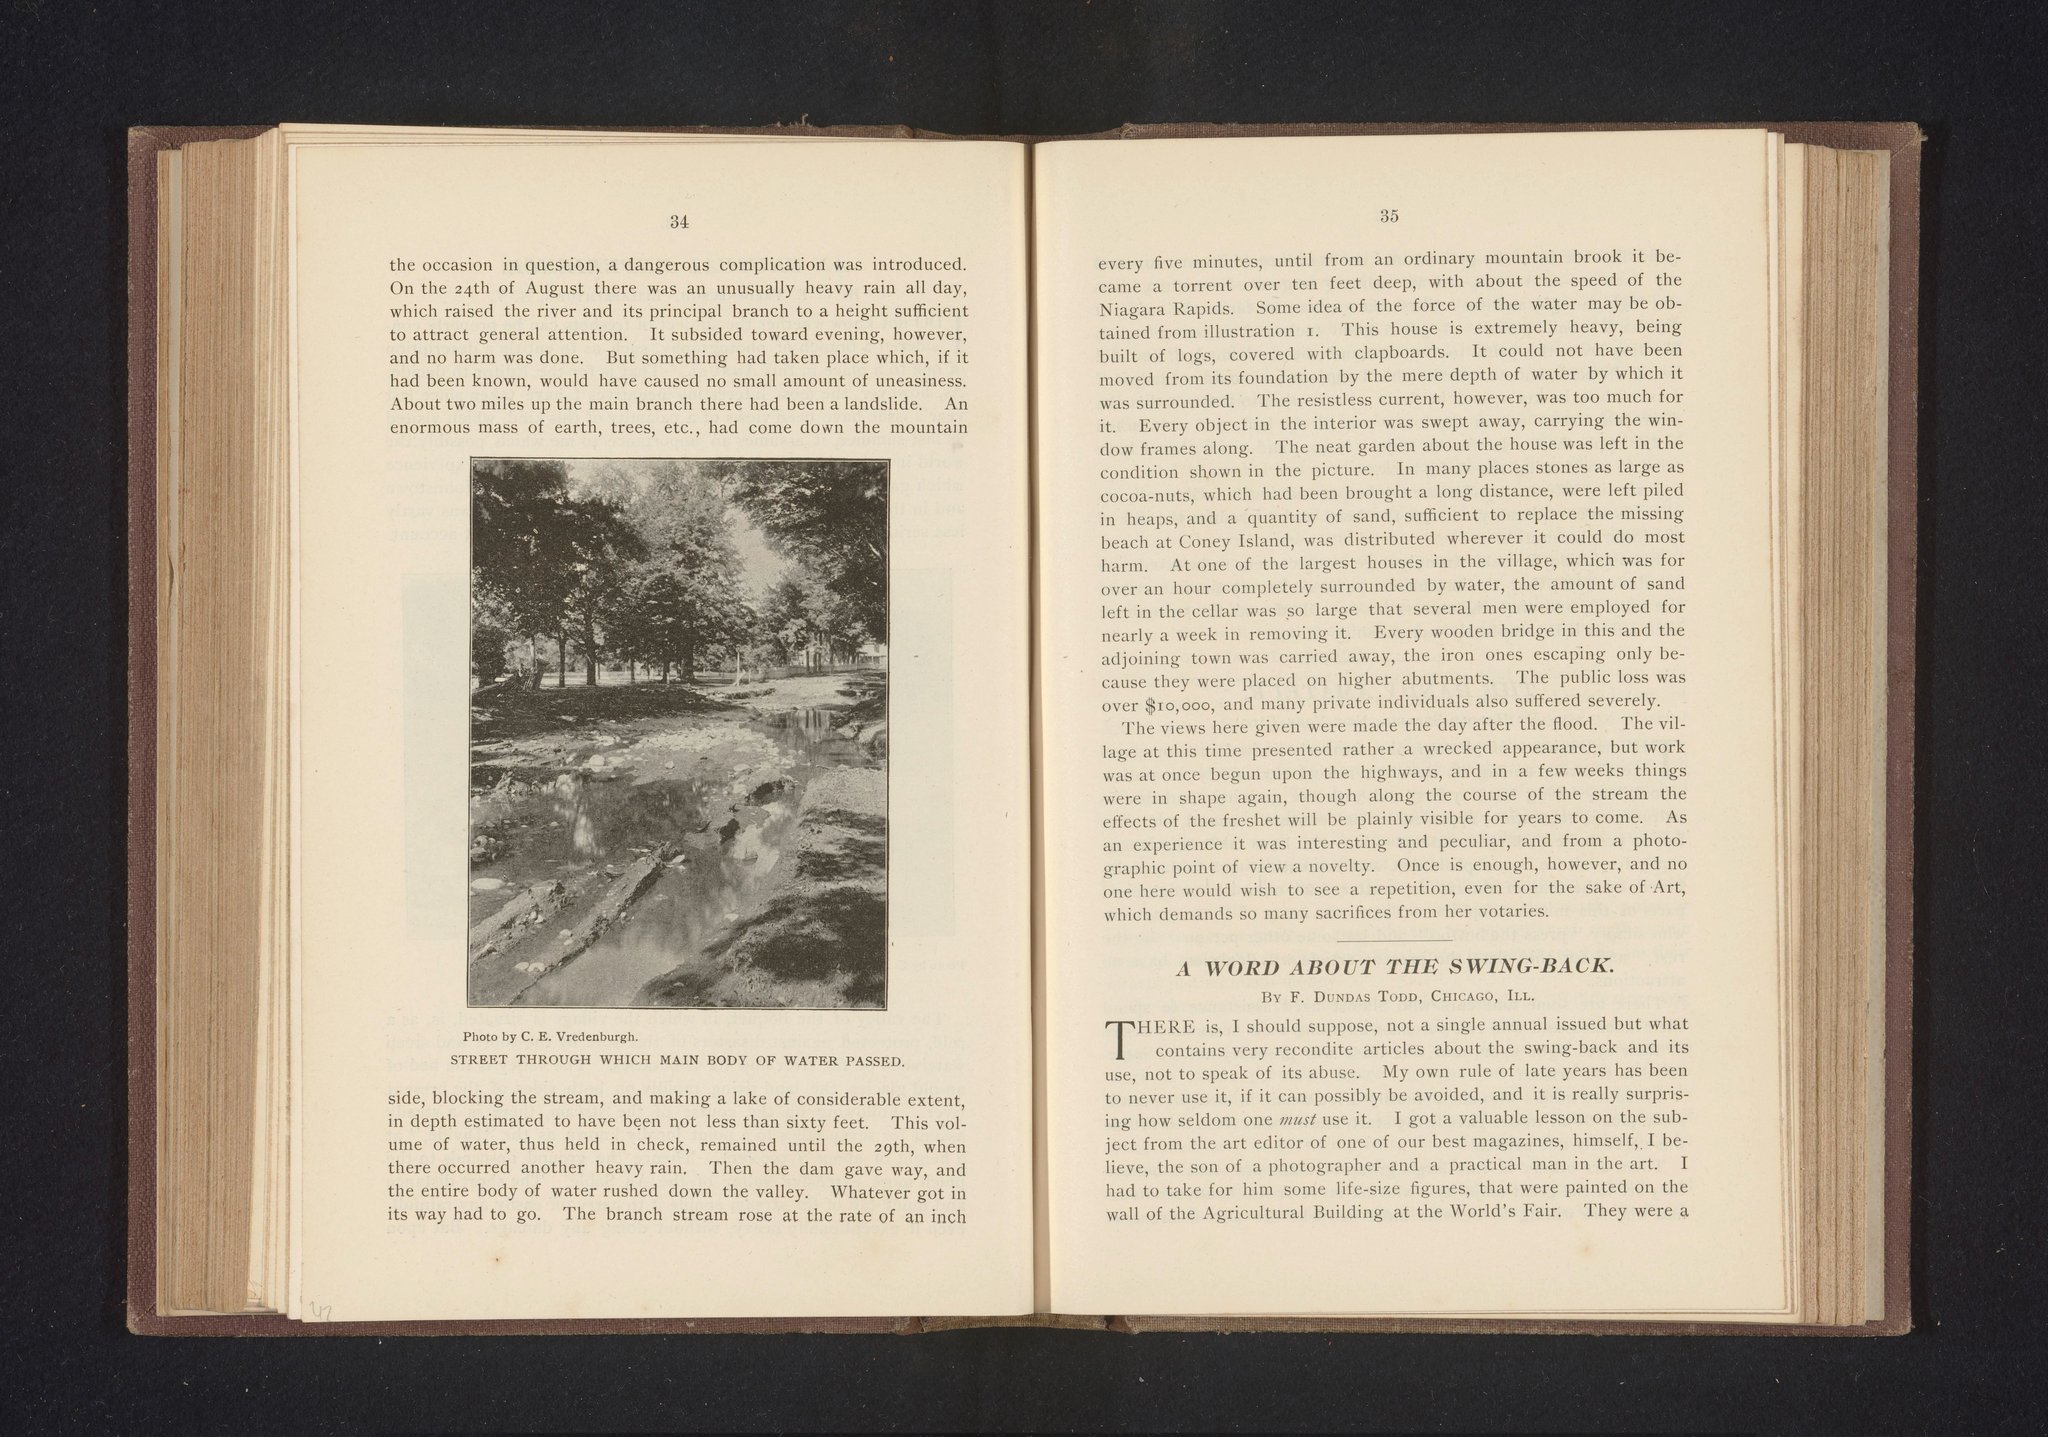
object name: photomechanical print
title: Street through which main body of water passed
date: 1890-1895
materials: paper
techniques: autotype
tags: flood, high tide, street